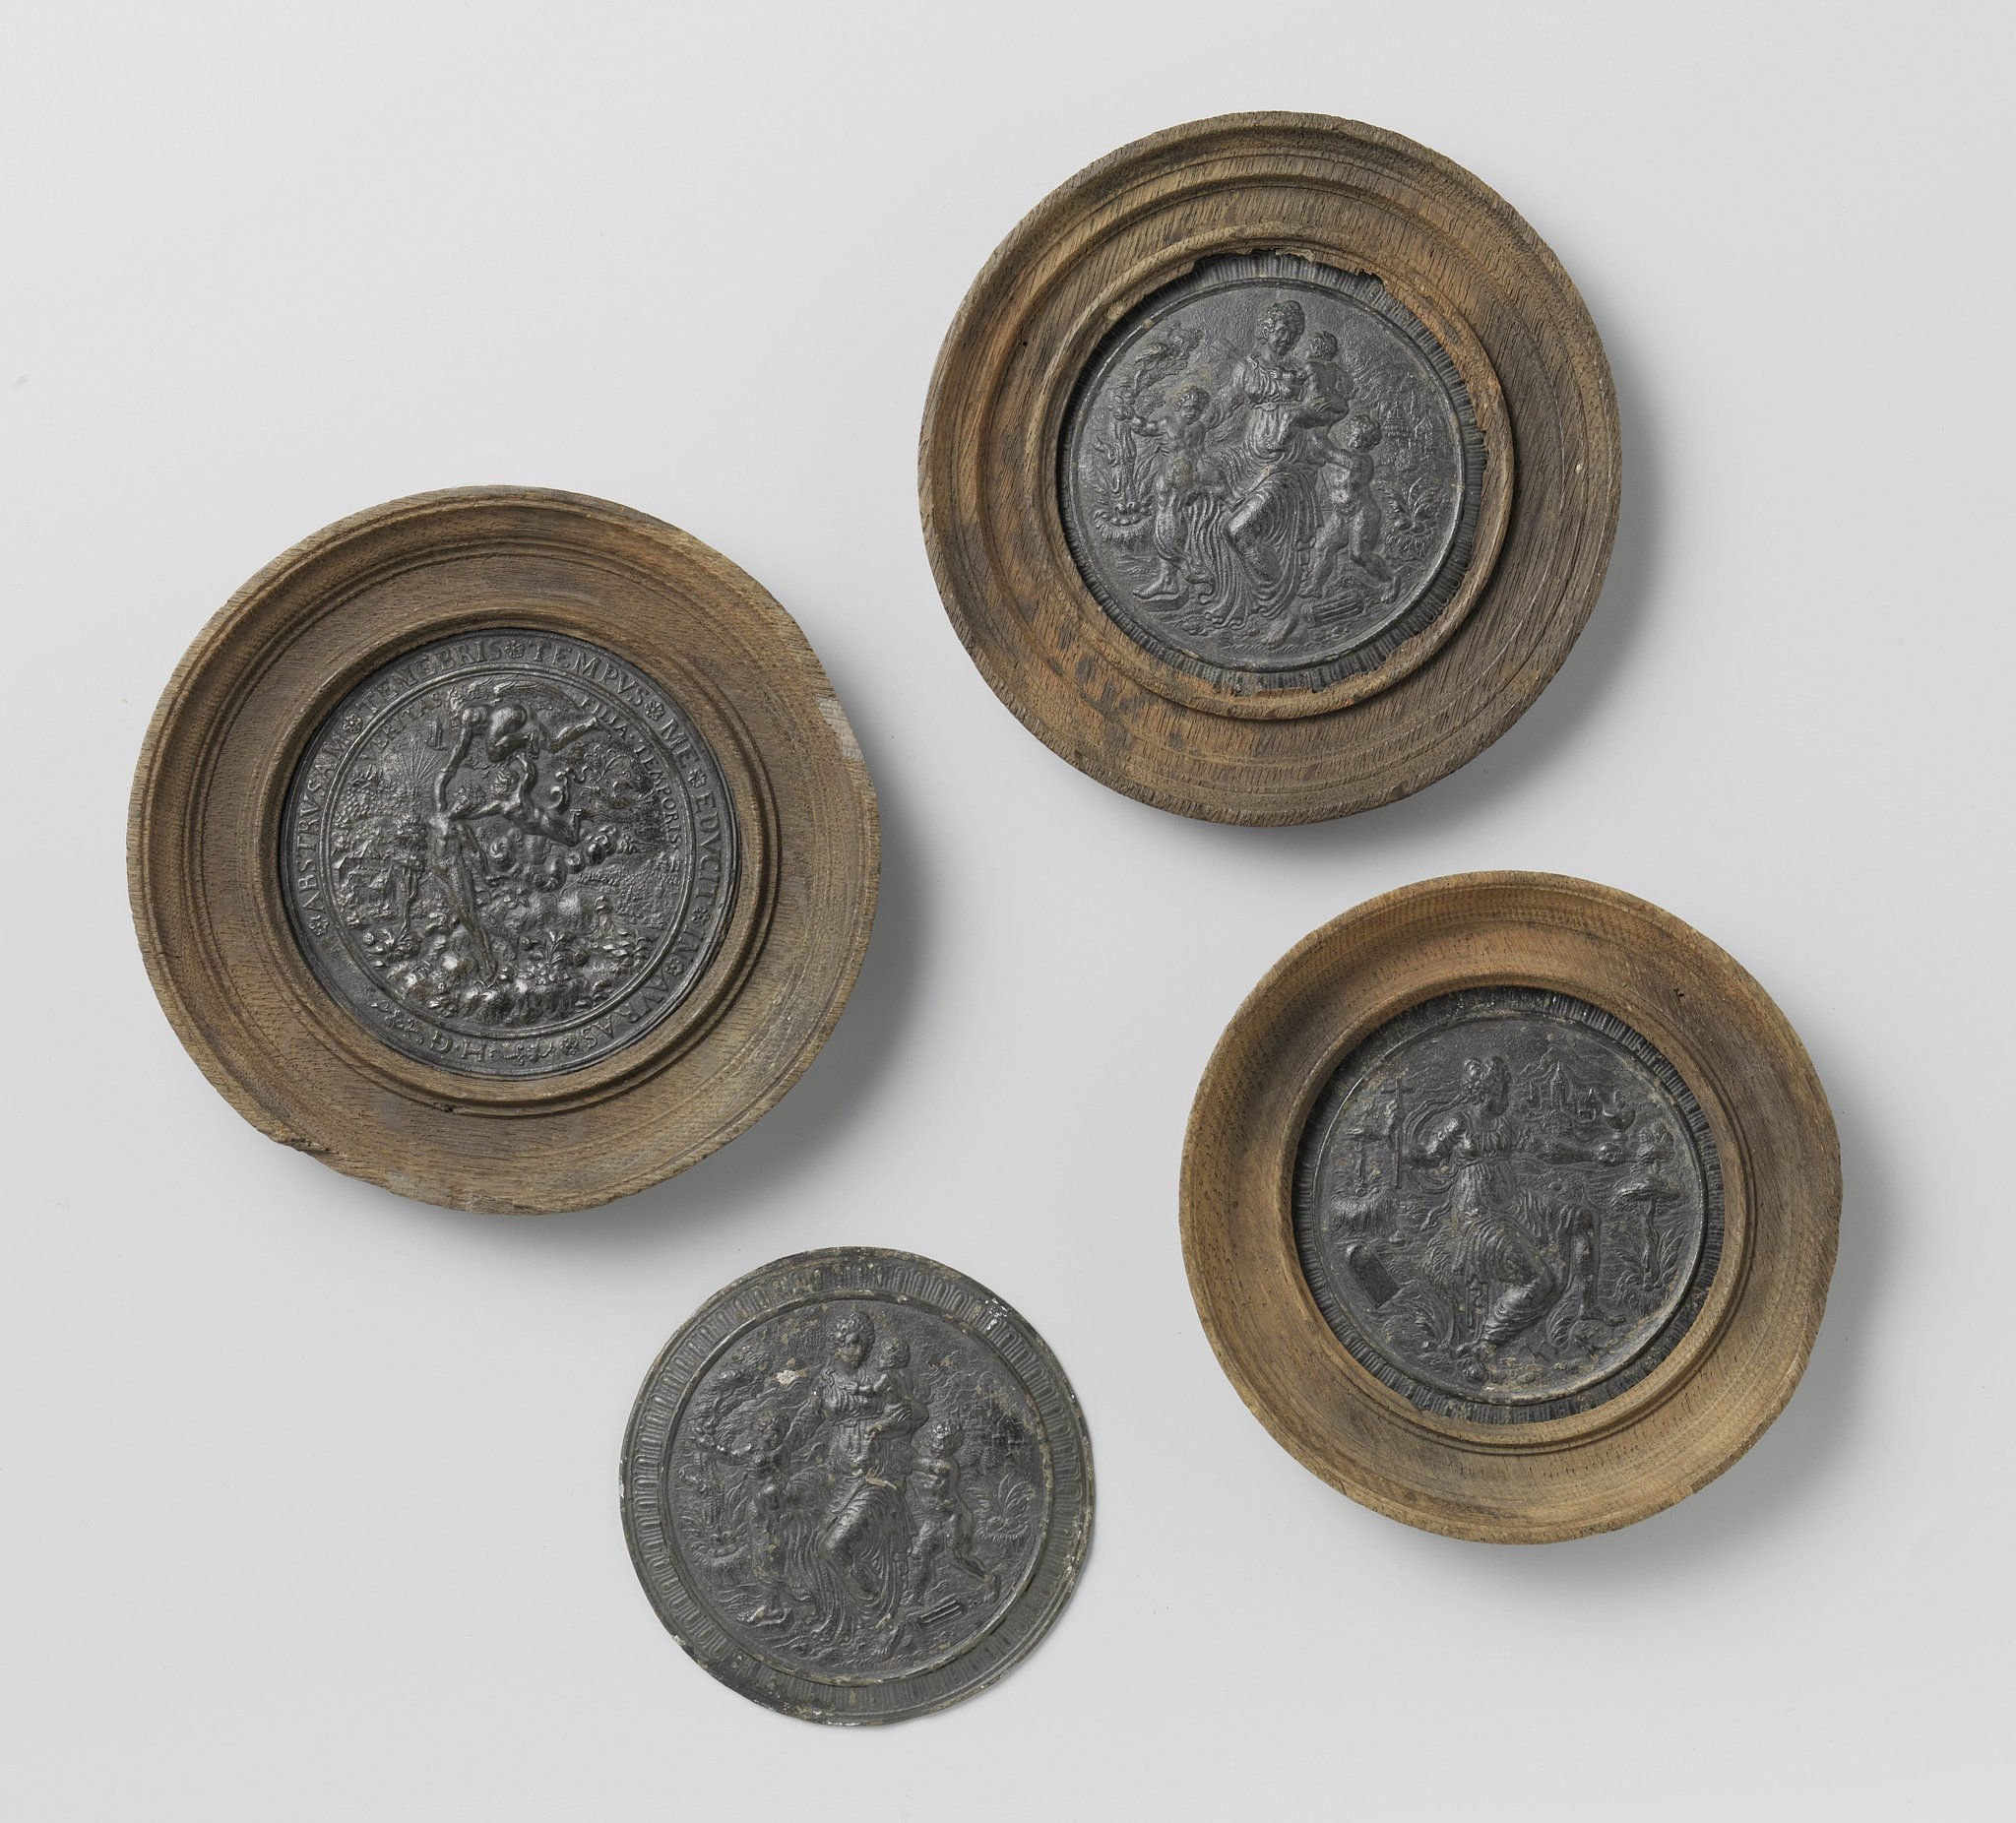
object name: locket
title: Eierlijst behorende bij plaquette met allegorische voorstelling over De Trouw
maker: Anonymous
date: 1590-1596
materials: wood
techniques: cutting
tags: willem barendsz., jacob van heemskerck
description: Eierlijst van hout behorende bij de plaquette met allegorische voorstelling over De Trouw.